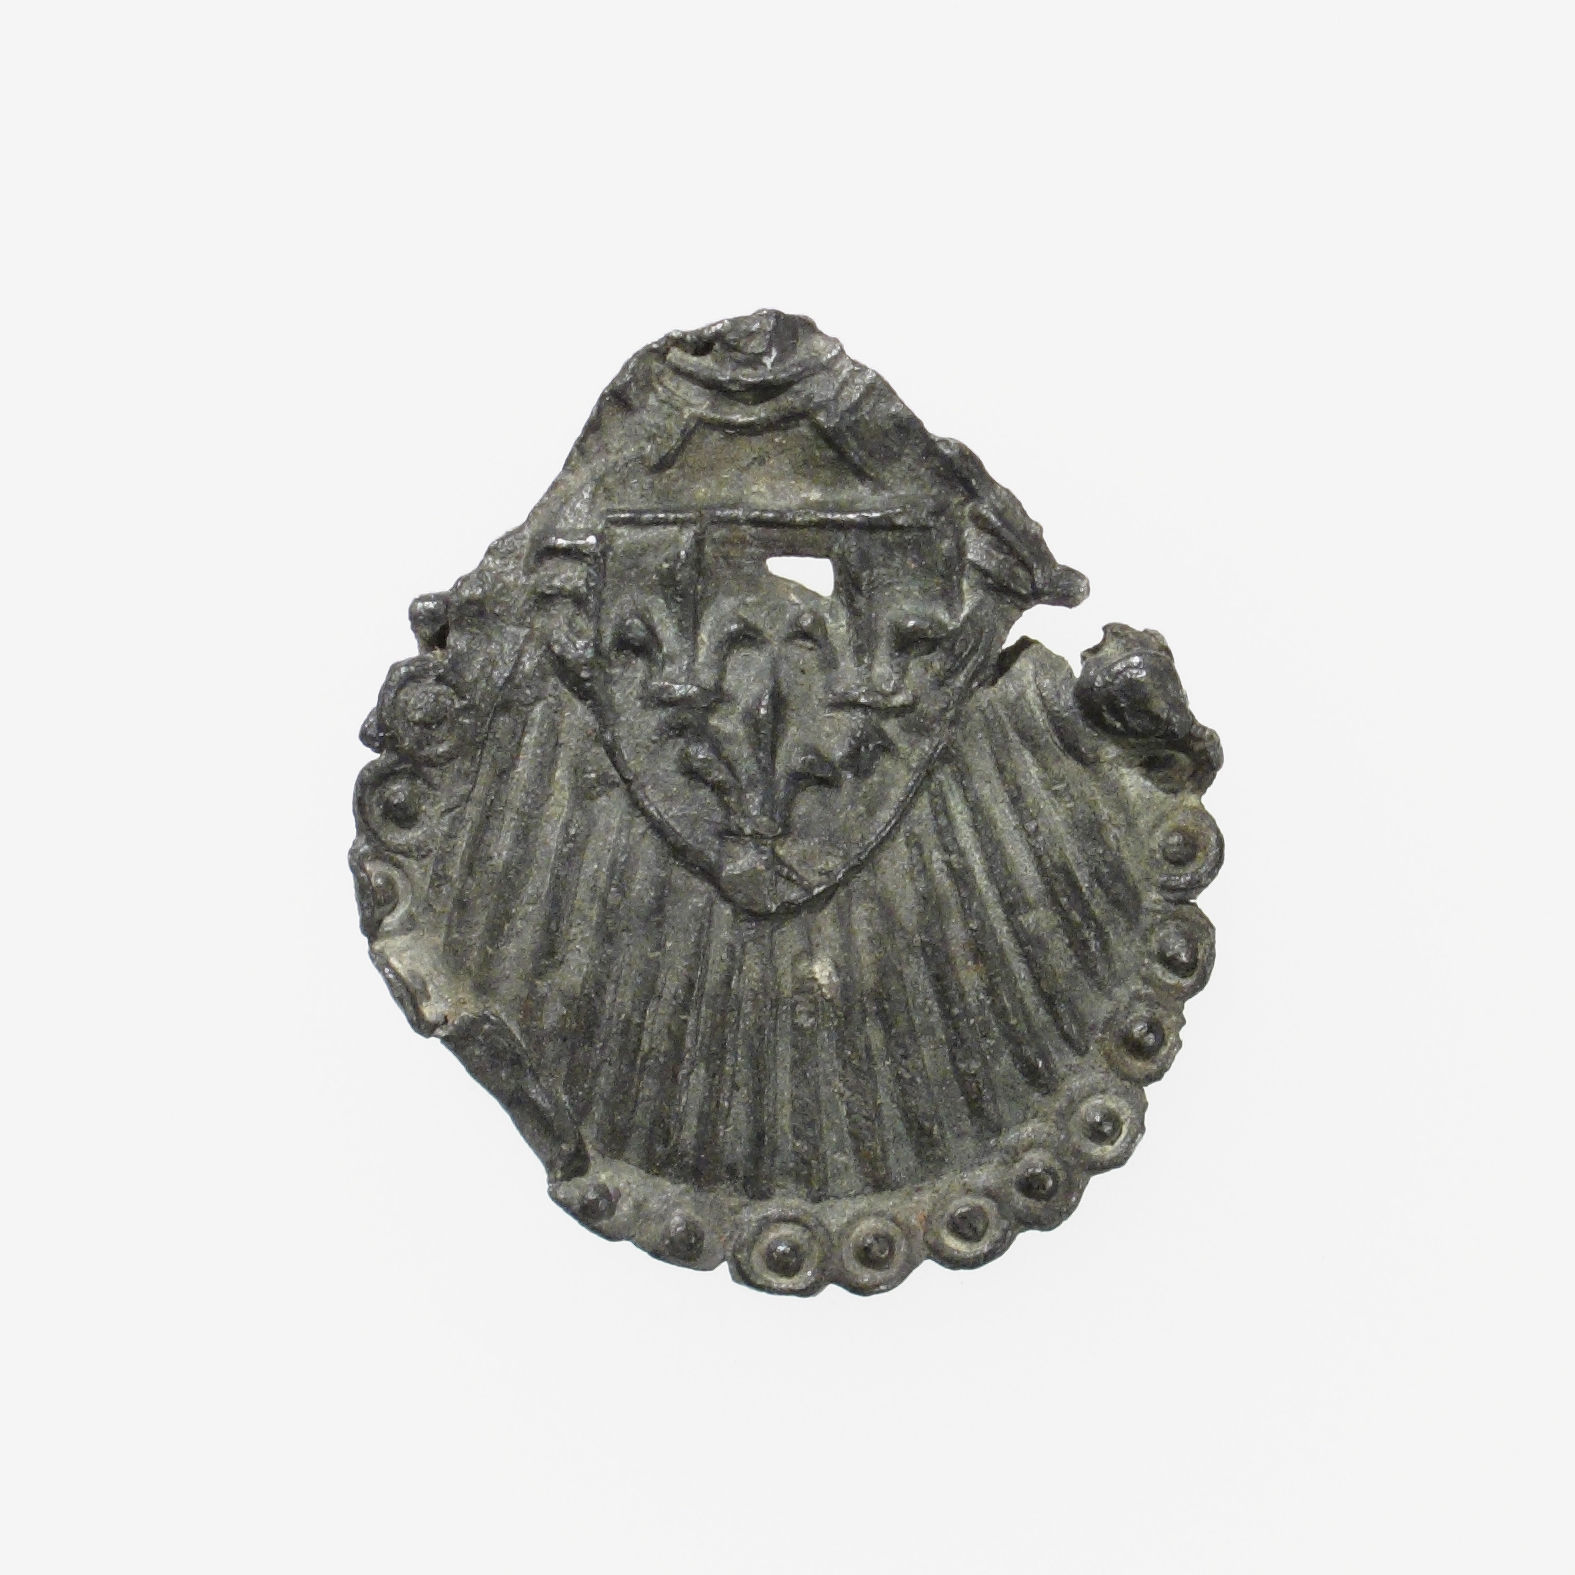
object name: pilgrim's badge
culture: french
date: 1401-1500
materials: lead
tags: shells